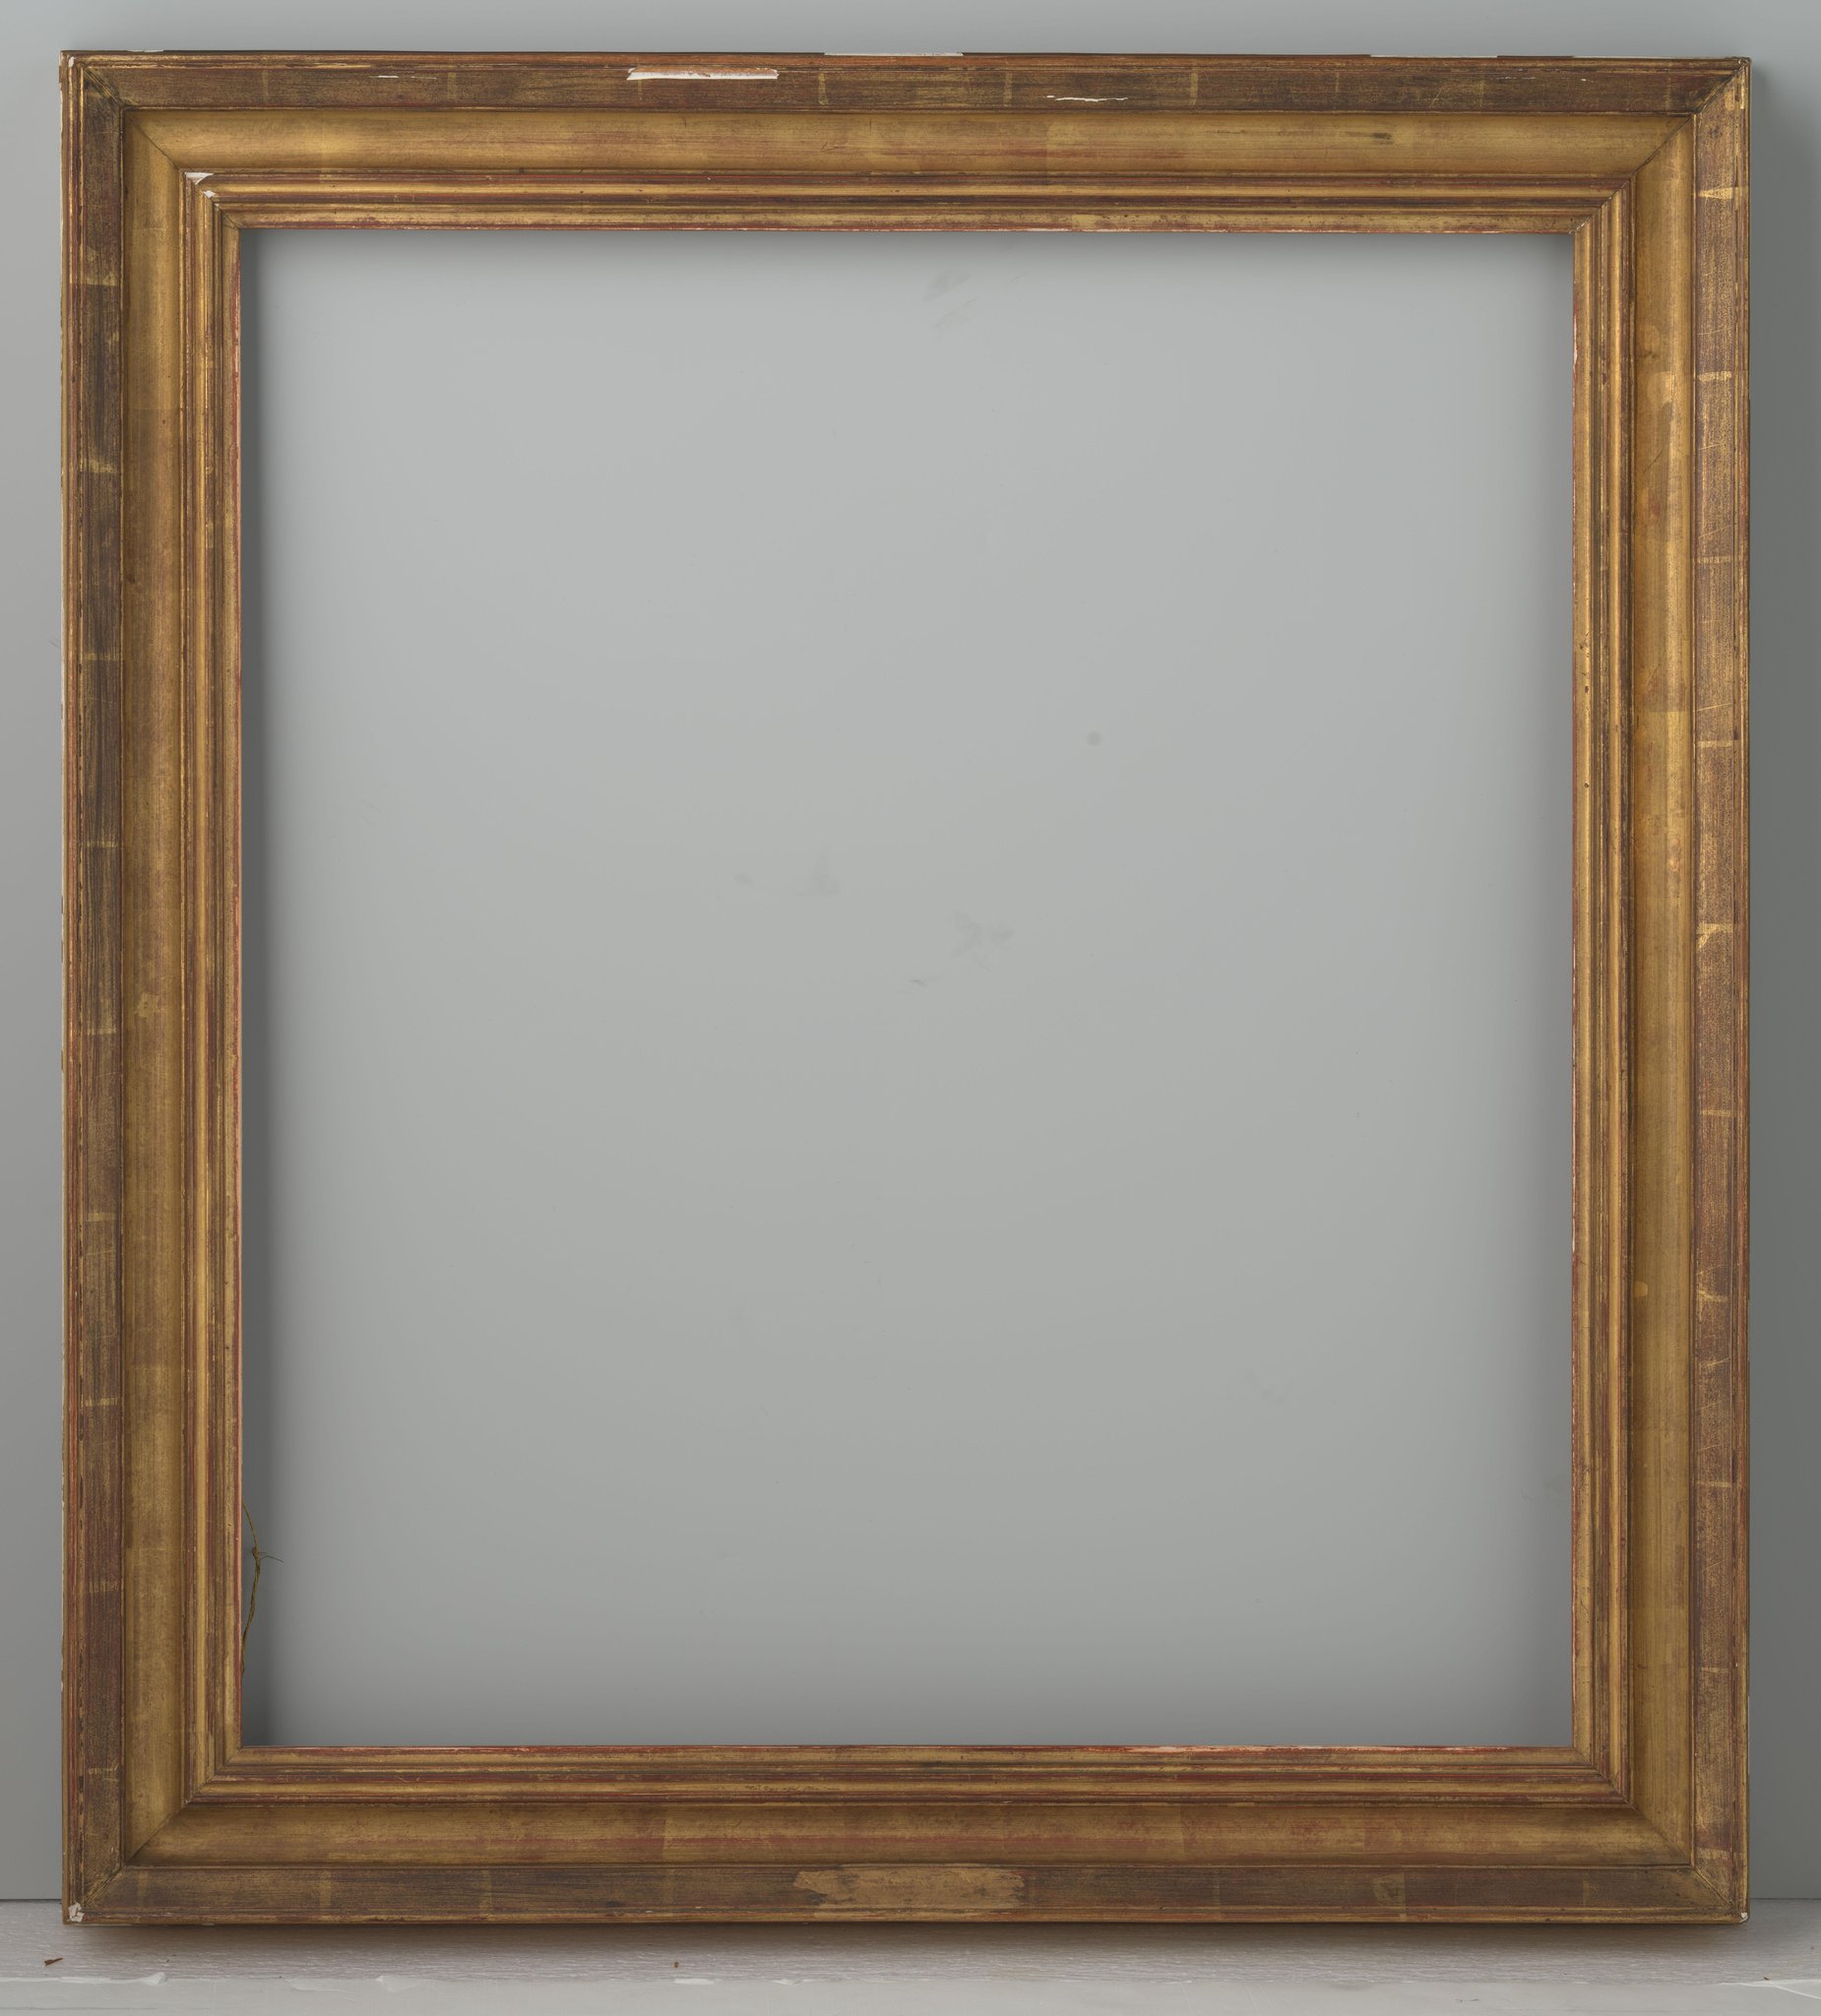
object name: frame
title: Vergulde profiellijst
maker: Anonymous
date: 1850-1949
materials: gold leaf, wood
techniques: gilding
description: Vergulde profiellijst met schuinoplopende buitenrand. De hoekverbindingen zijn koud verstekt en met spijkers verstevigd.